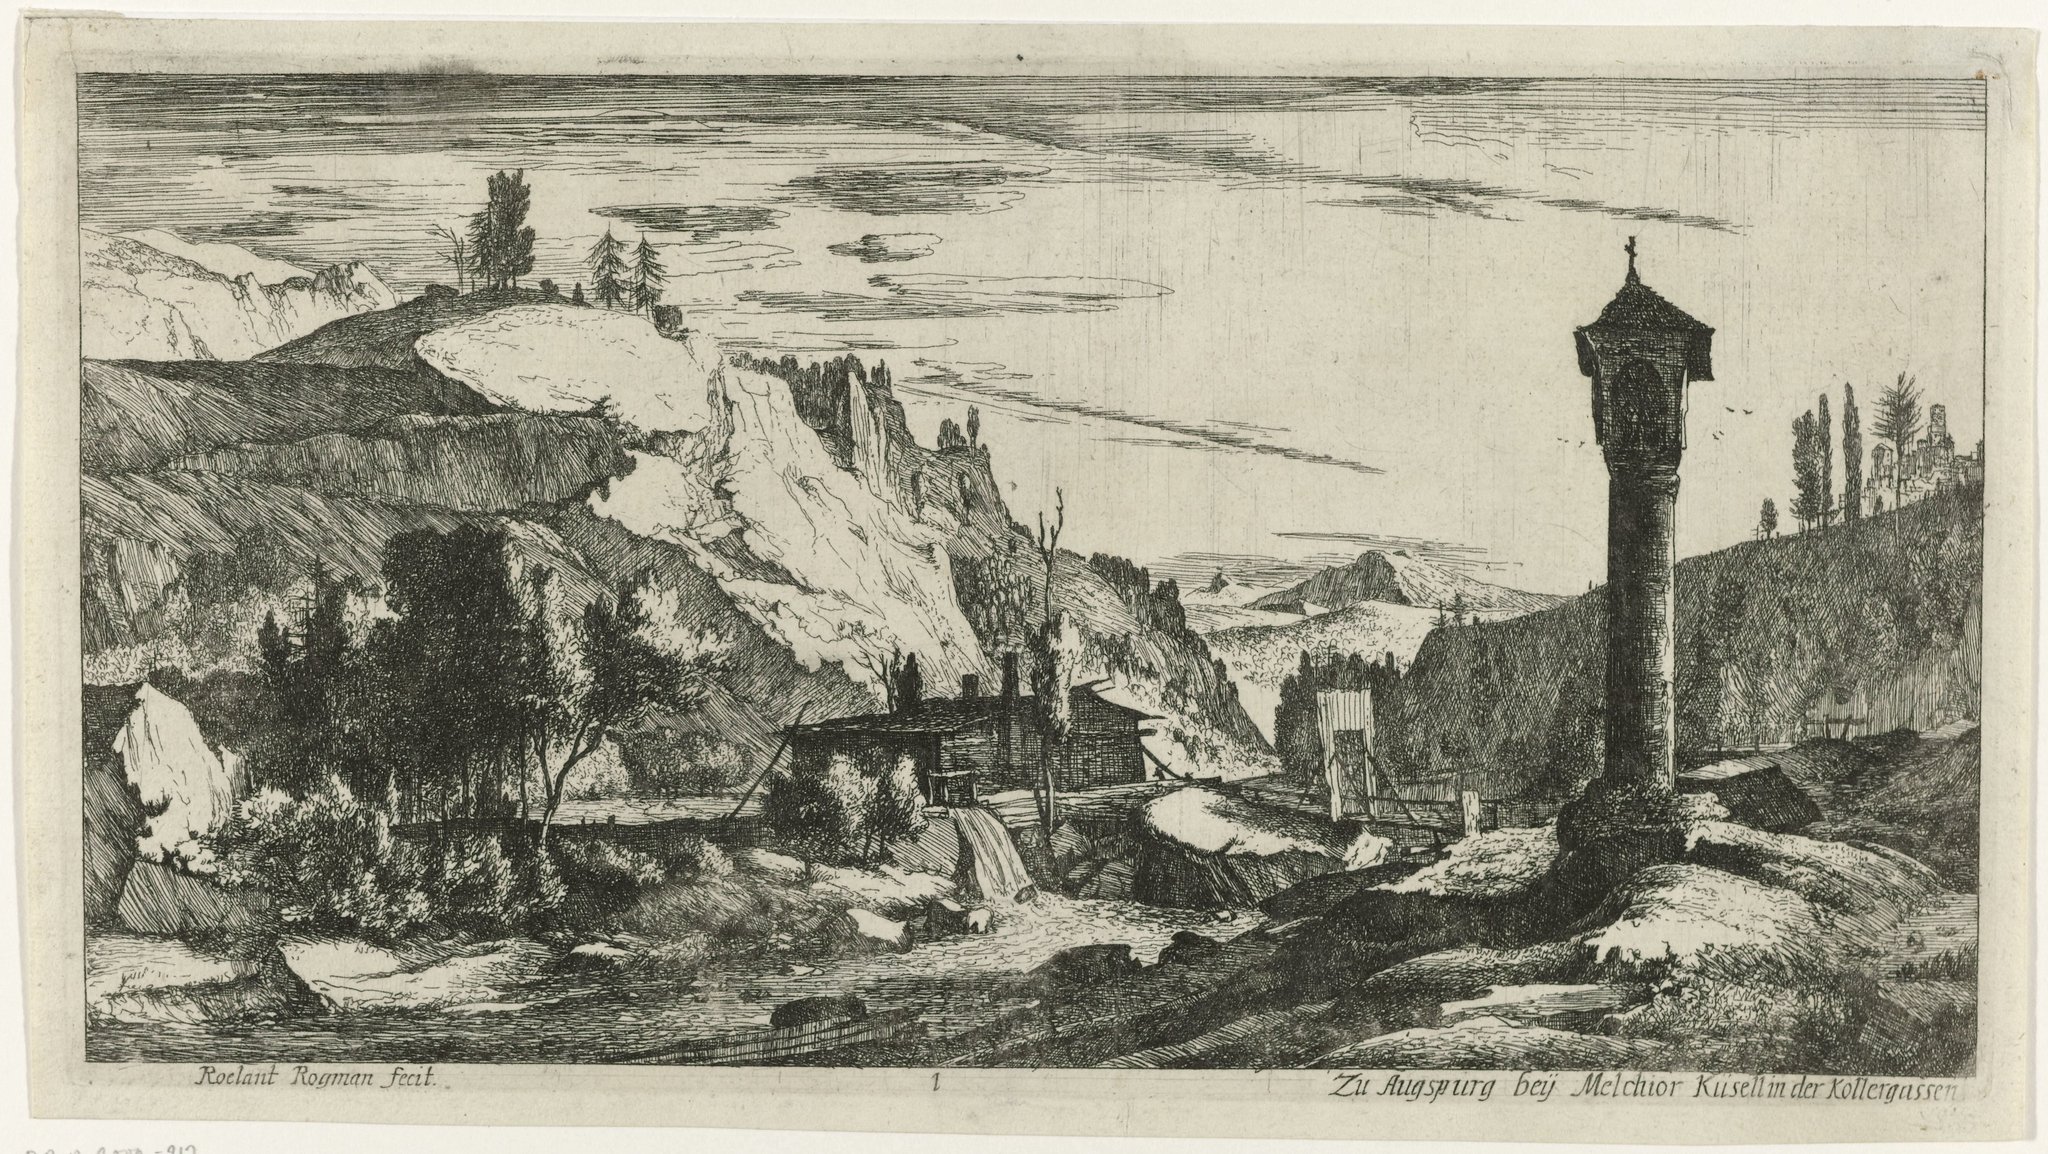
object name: print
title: Tiroolse landschappen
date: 1647-1692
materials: paper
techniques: etching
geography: amsterdam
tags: column, pillar ~ architecture, landscapes in the temperate zone, landscape with bridge, viaduct or aqueduct, rural housing, e.g. country-house, villa, cottage, mountains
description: Gezicht op een berglandschap in Tirol, met op de voorgrond een zuil met gedenkteken. Temidden van de bergen en rotsen een brug, die naar een hut bij een stroom leidt. Rechts op de achtergrond de contouren van een stad. Prent uit een serie van acht prenten met Tiroolse landschappen.